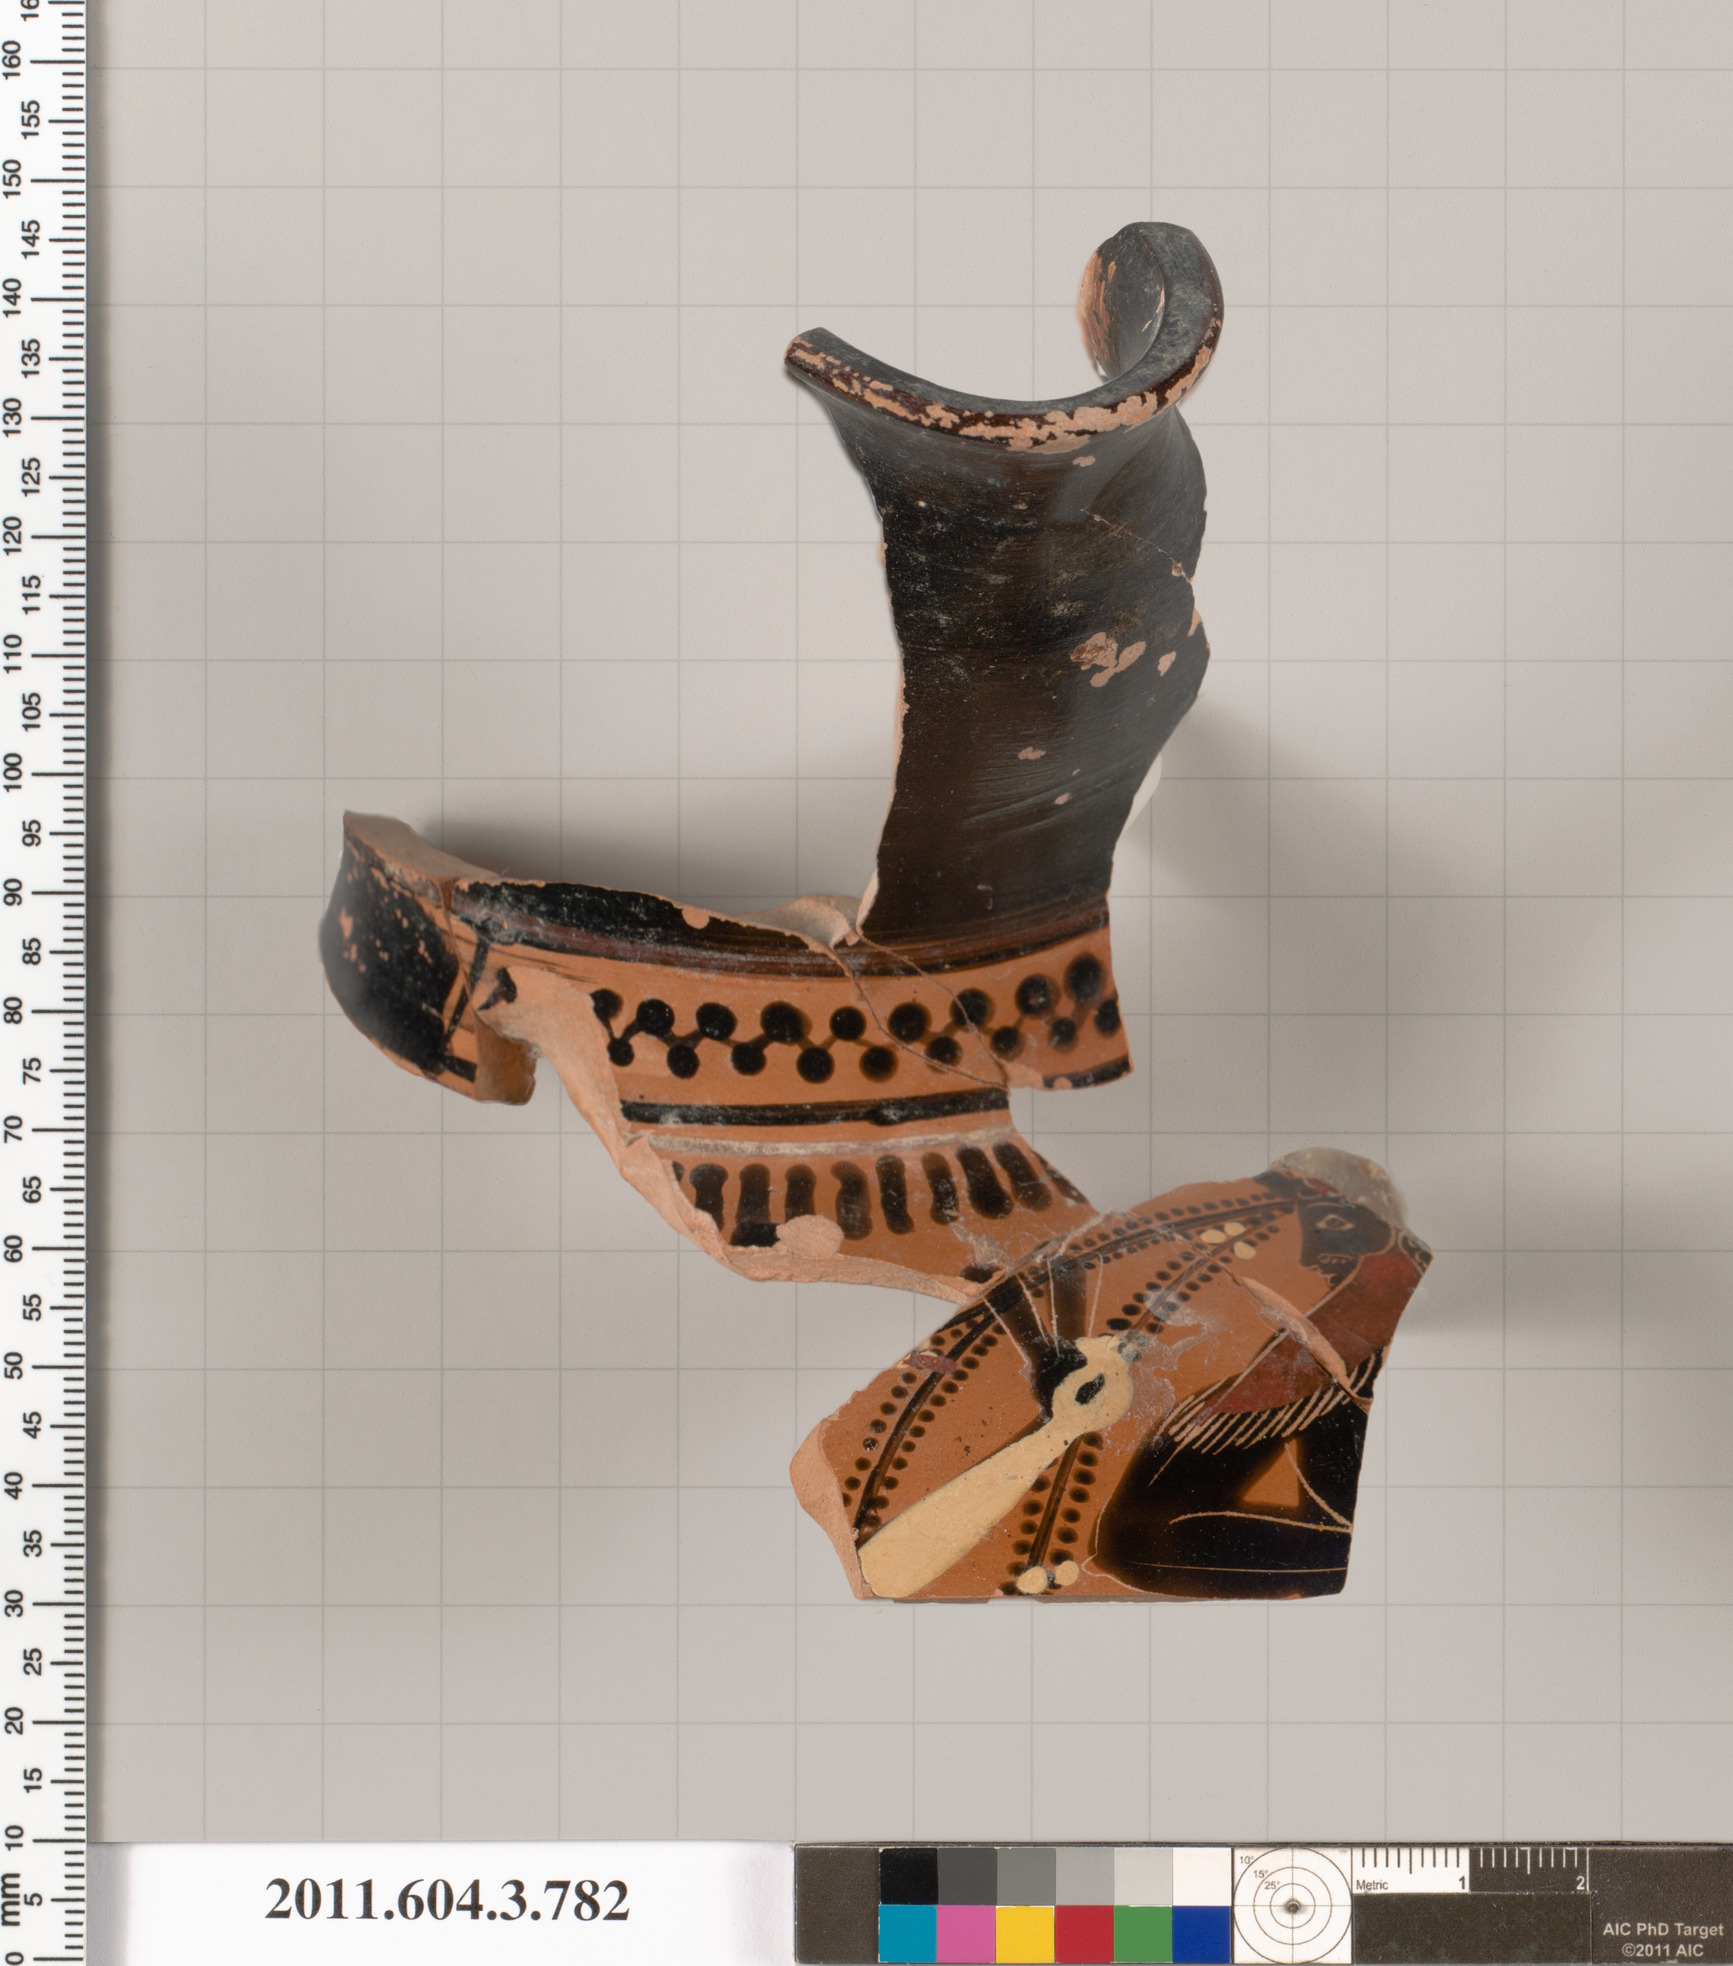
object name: oinochoe fragment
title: Terracotta fragment of an oinochoe (jug)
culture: greek, attic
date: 534-501 BCE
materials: terracotta